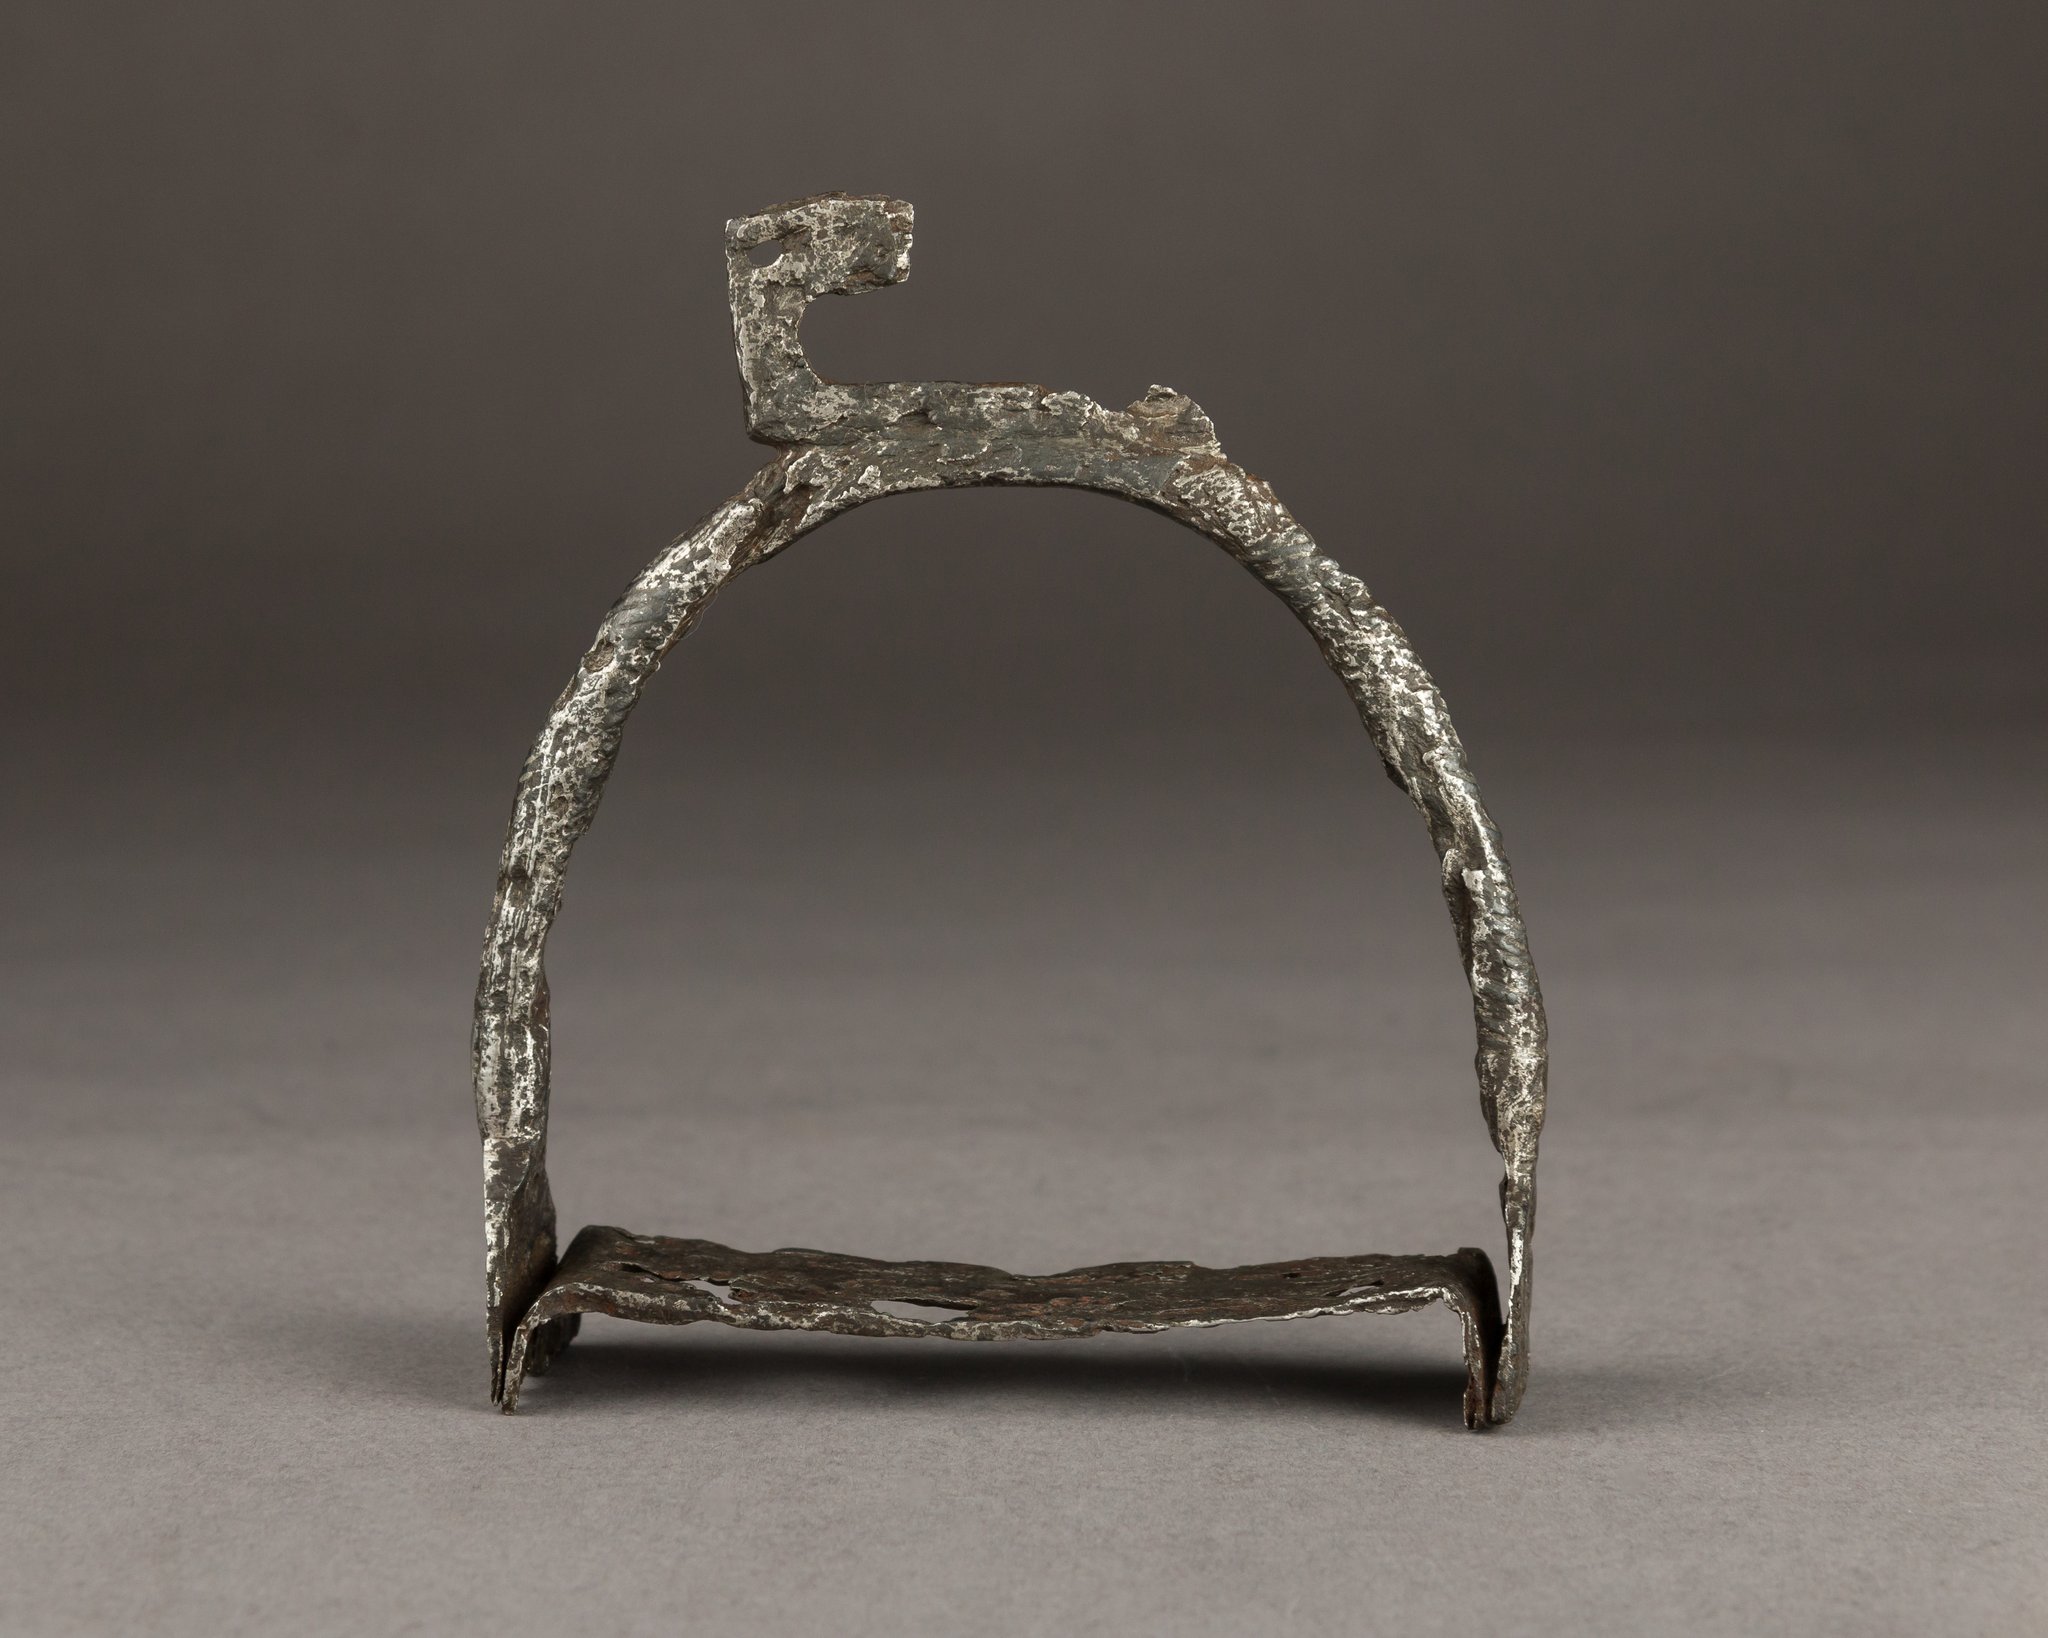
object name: stirrup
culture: germanic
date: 901-1100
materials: iron, silver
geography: poland